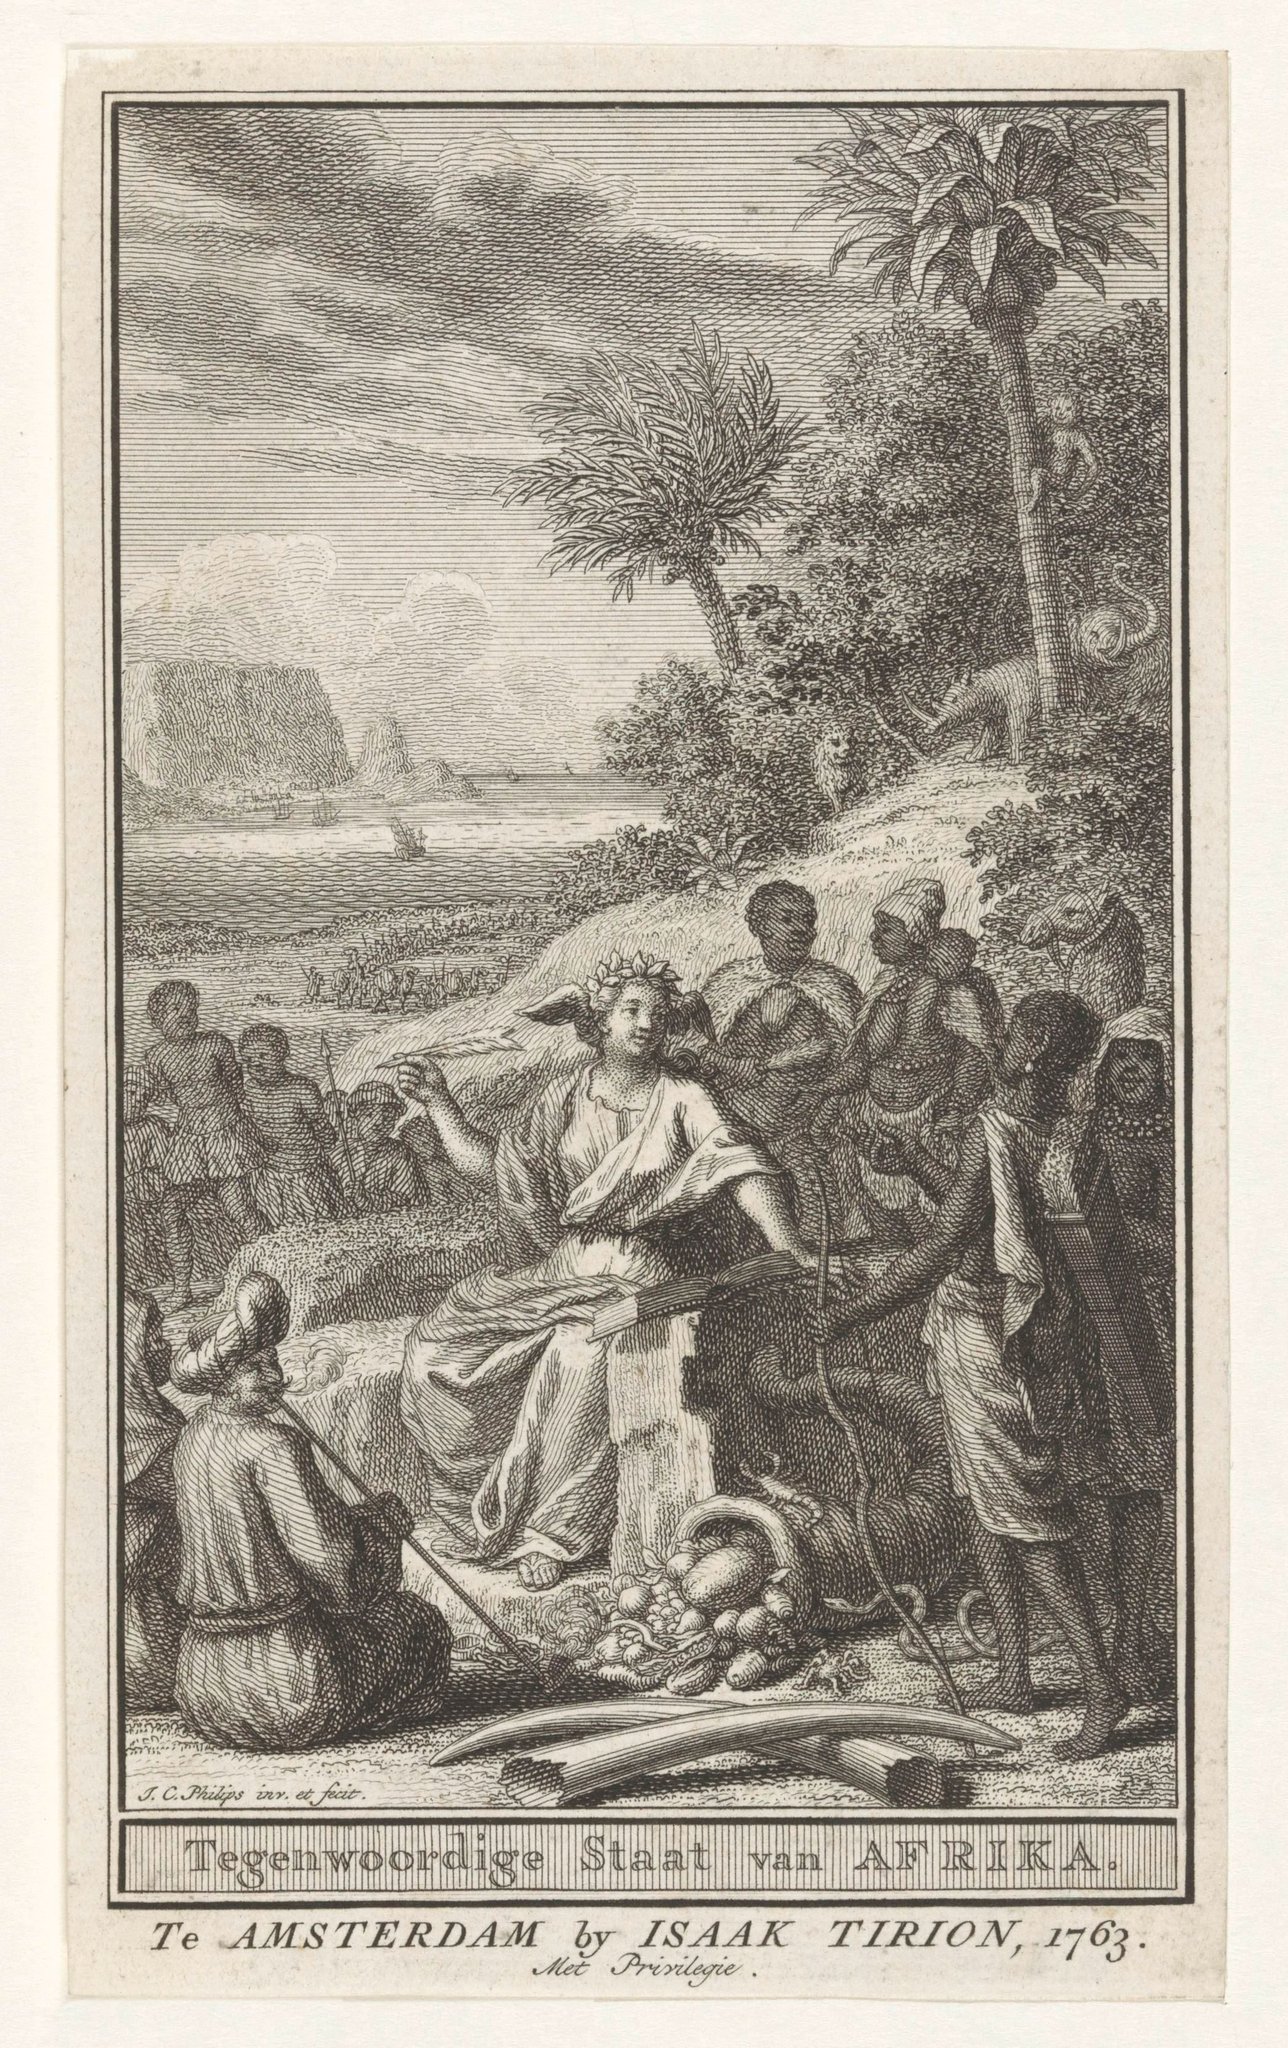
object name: print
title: Allegorie op Afrika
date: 1763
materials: paper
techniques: engraving, etching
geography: amsterdam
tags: africa represented allegorically; 'africa' (ripa), africans, 'historia'; 'historia' (ripa)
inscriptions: collector's mark: Lugt 2228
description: Een vrouw met vleugels aan het hoofd (mogelijk Geschiedenis) zit met schrijfveer en boek. Rechts staat een groep Afrikanen, onder wie een met een boog en pijlenkoker op de rug. Bij hen ligt een hoorn des overvloeds en slagtanden van olifanten. Links zit een gesluierde vrouw en een pijprokende man. Daarachter lopen Europeanen met geketende Afrikanen. In de achtergrond een Afrikaans landschap met kustgebied en oerwoud met dieren.